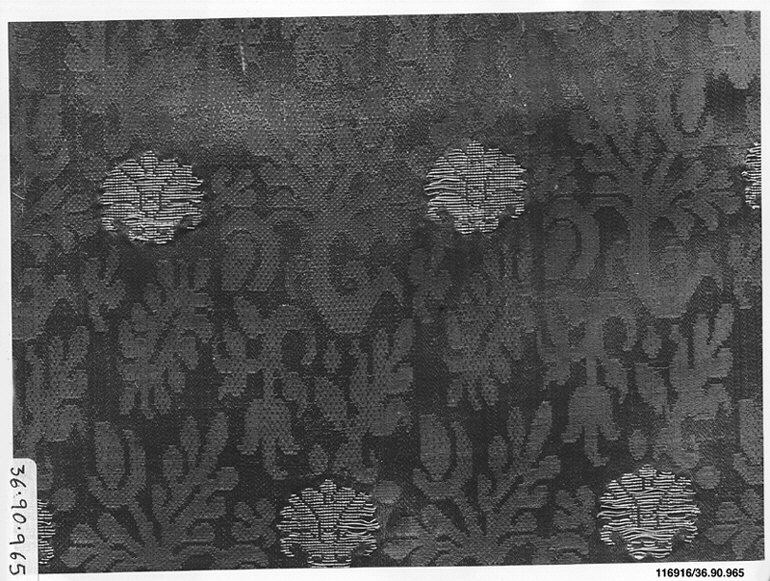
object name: piece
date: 1601-1700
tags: flowers